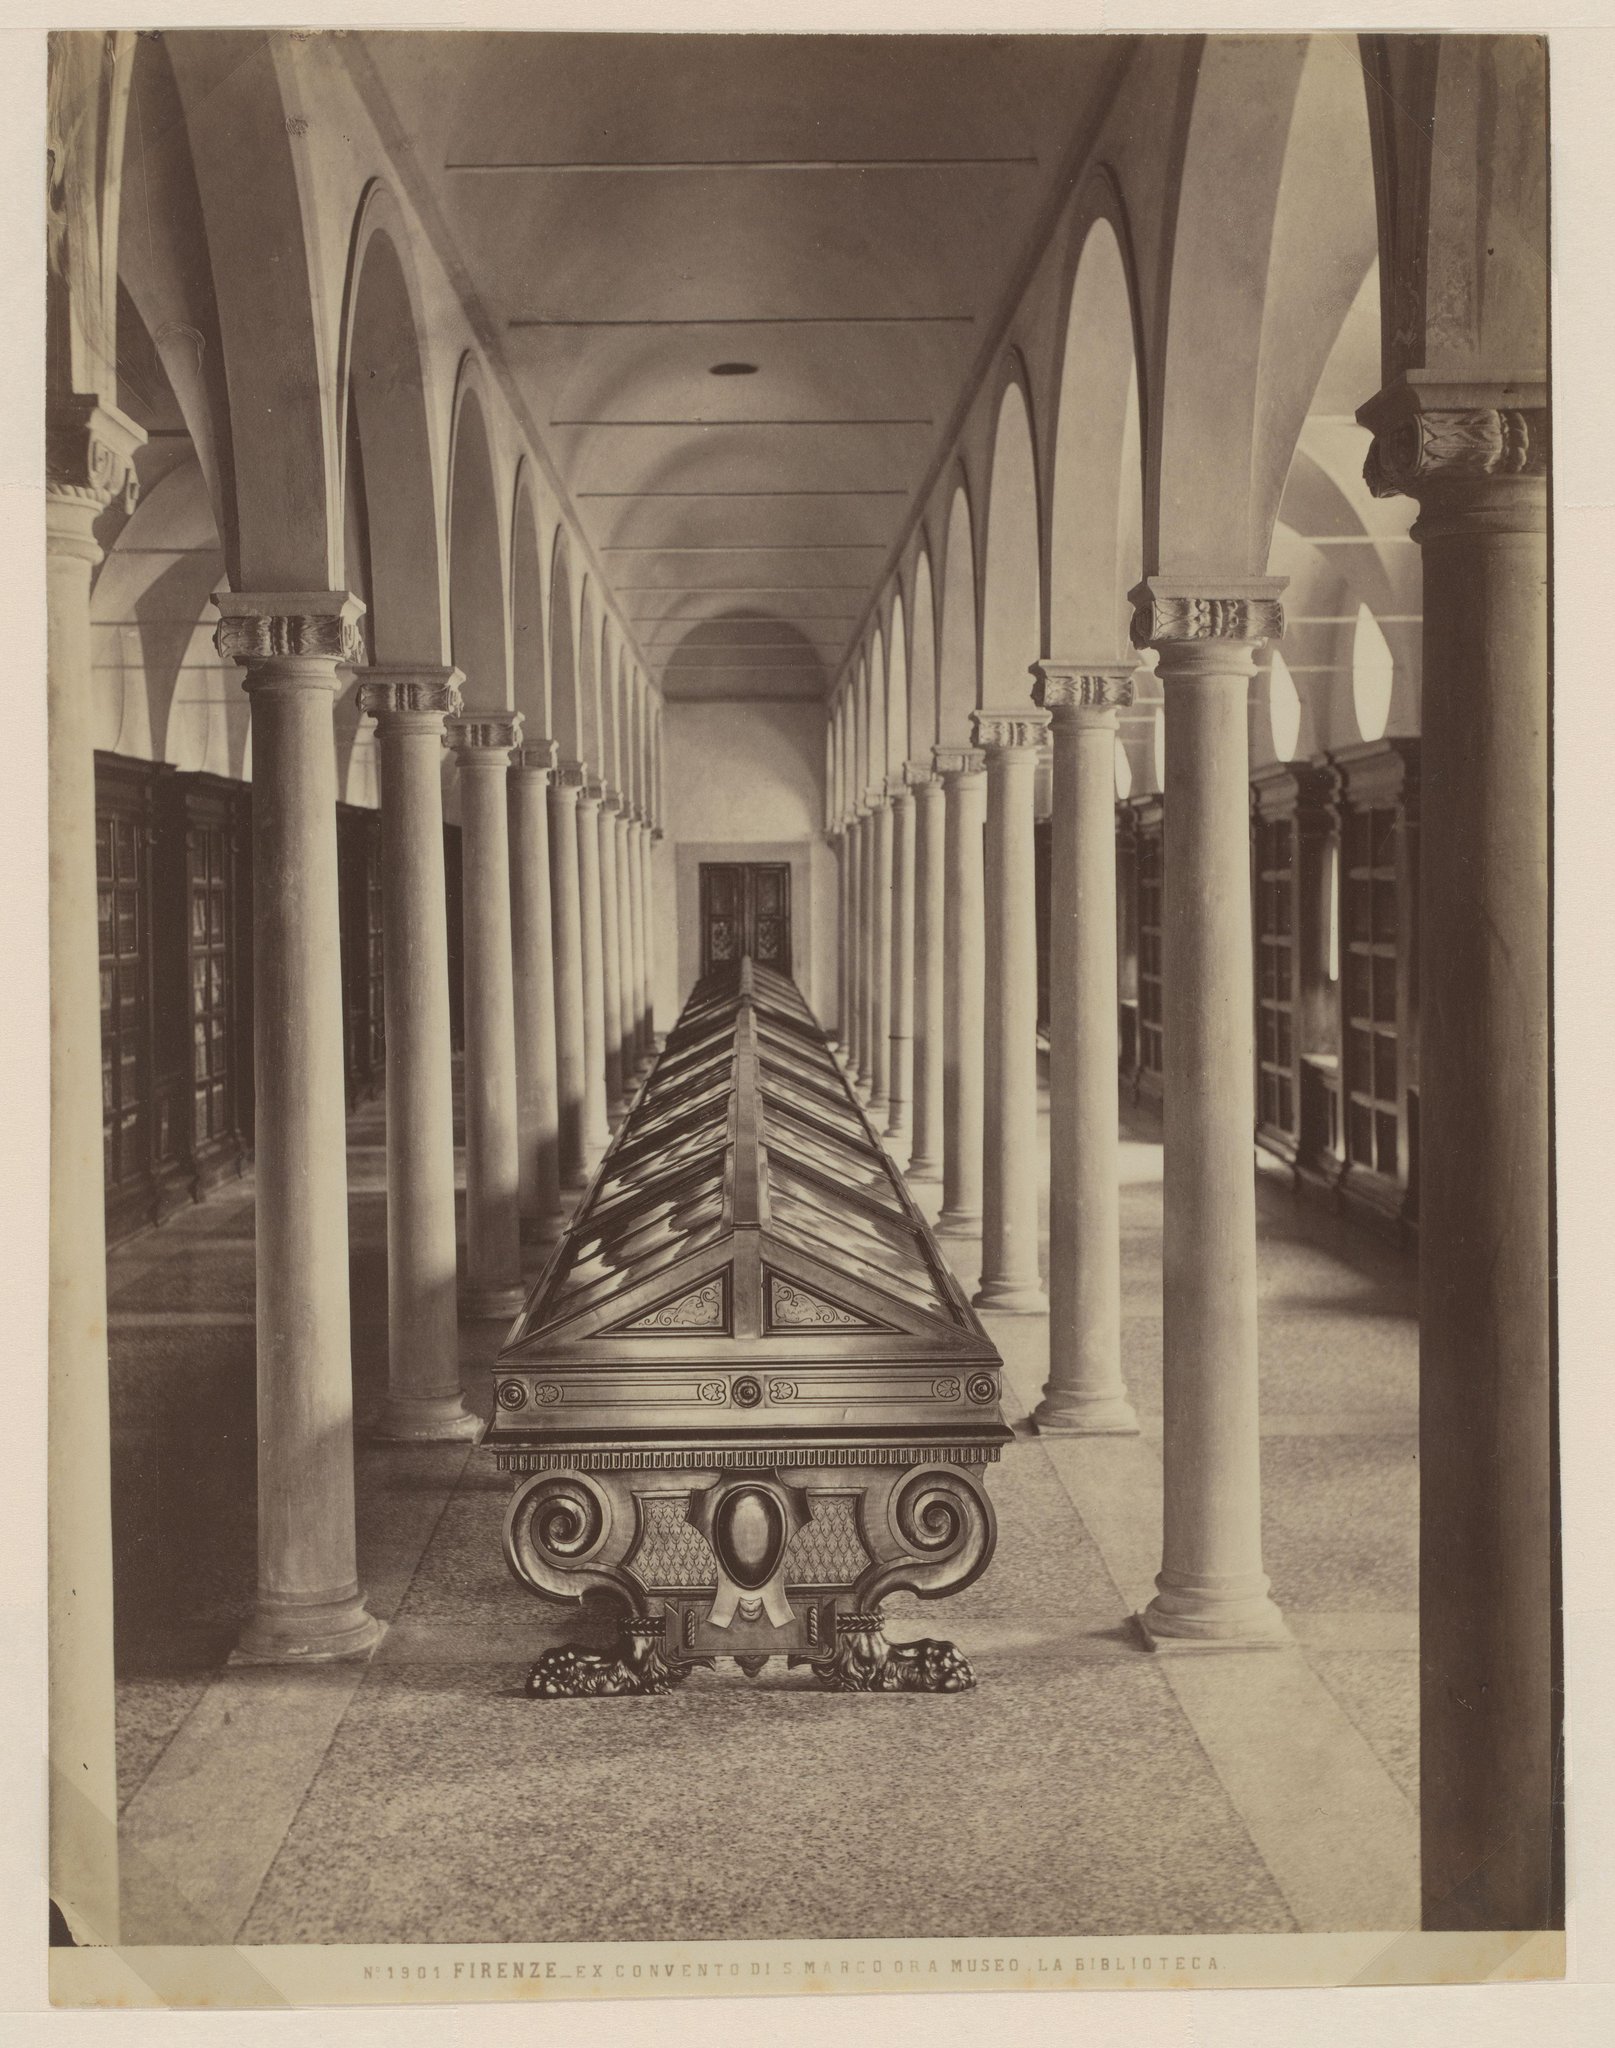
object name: photograph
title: Ex Convento di S. Marco ora Museo. La Biblioteca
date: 1857-1900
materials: paper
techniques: albumen print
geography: florence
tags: public library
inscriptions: number: ‘No. 1901’